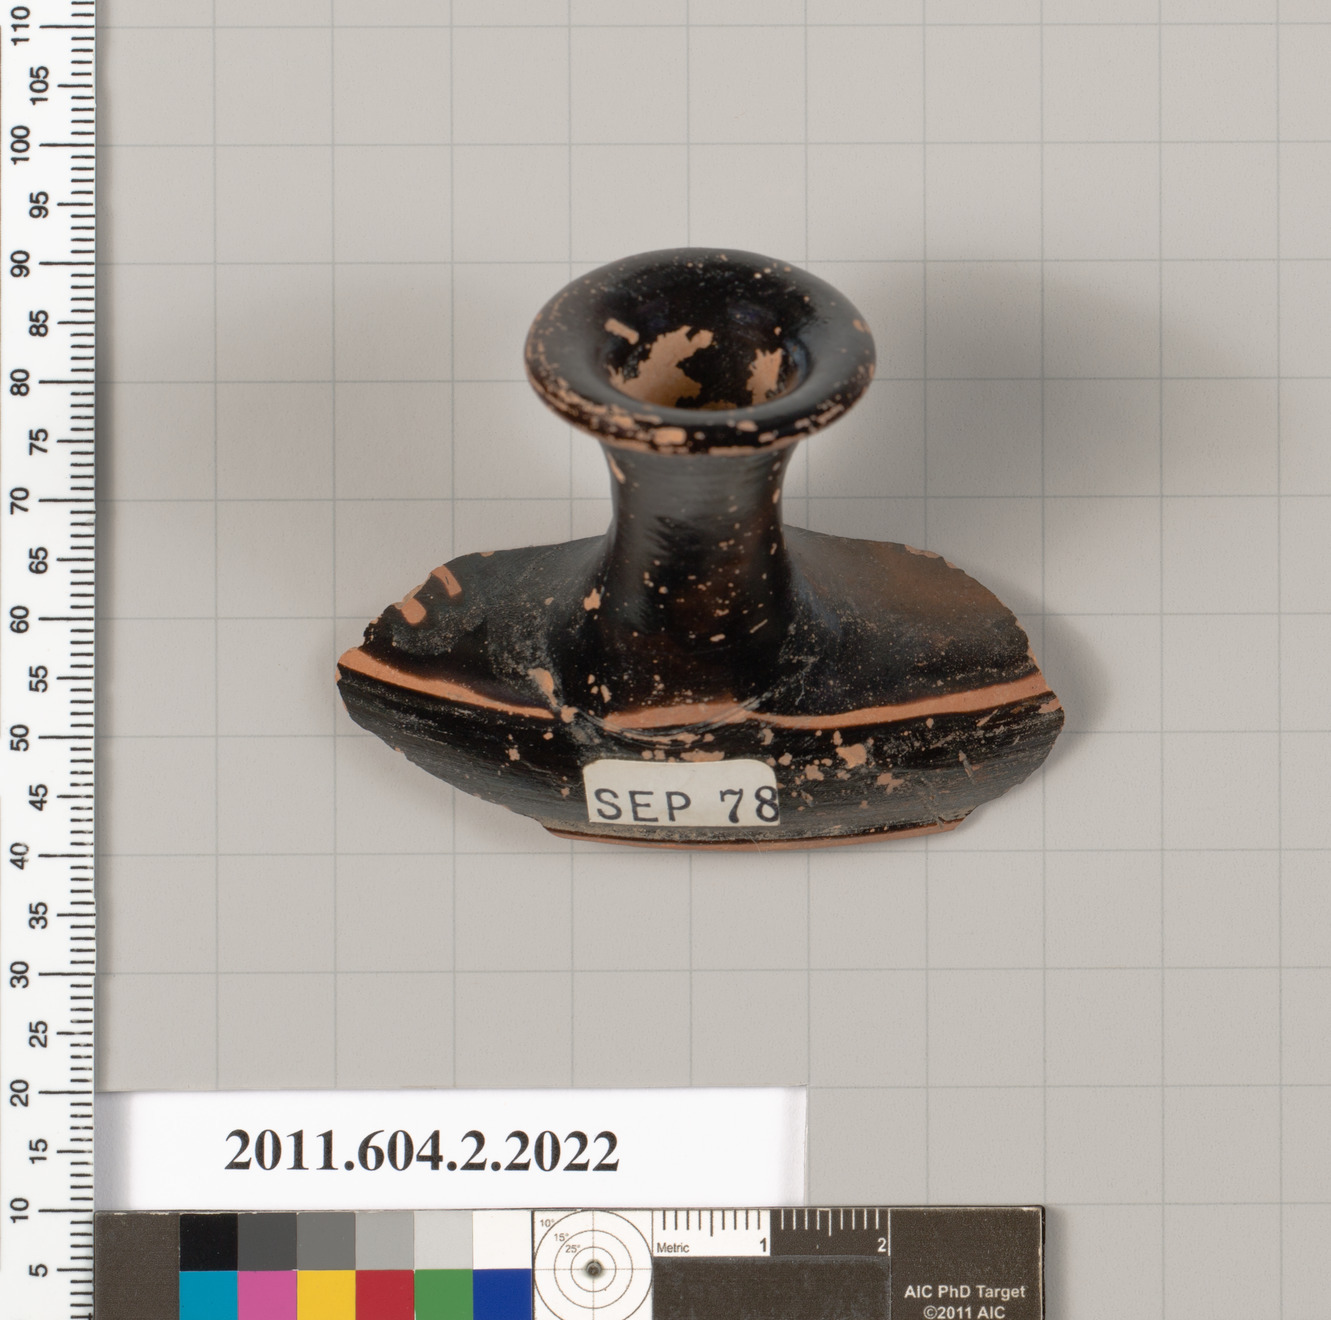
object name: askos fragment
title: Terracotta fragment of an askos (flask with a spout and handle over the top)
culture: greek, attic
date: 425-401 BCE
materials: terracotta